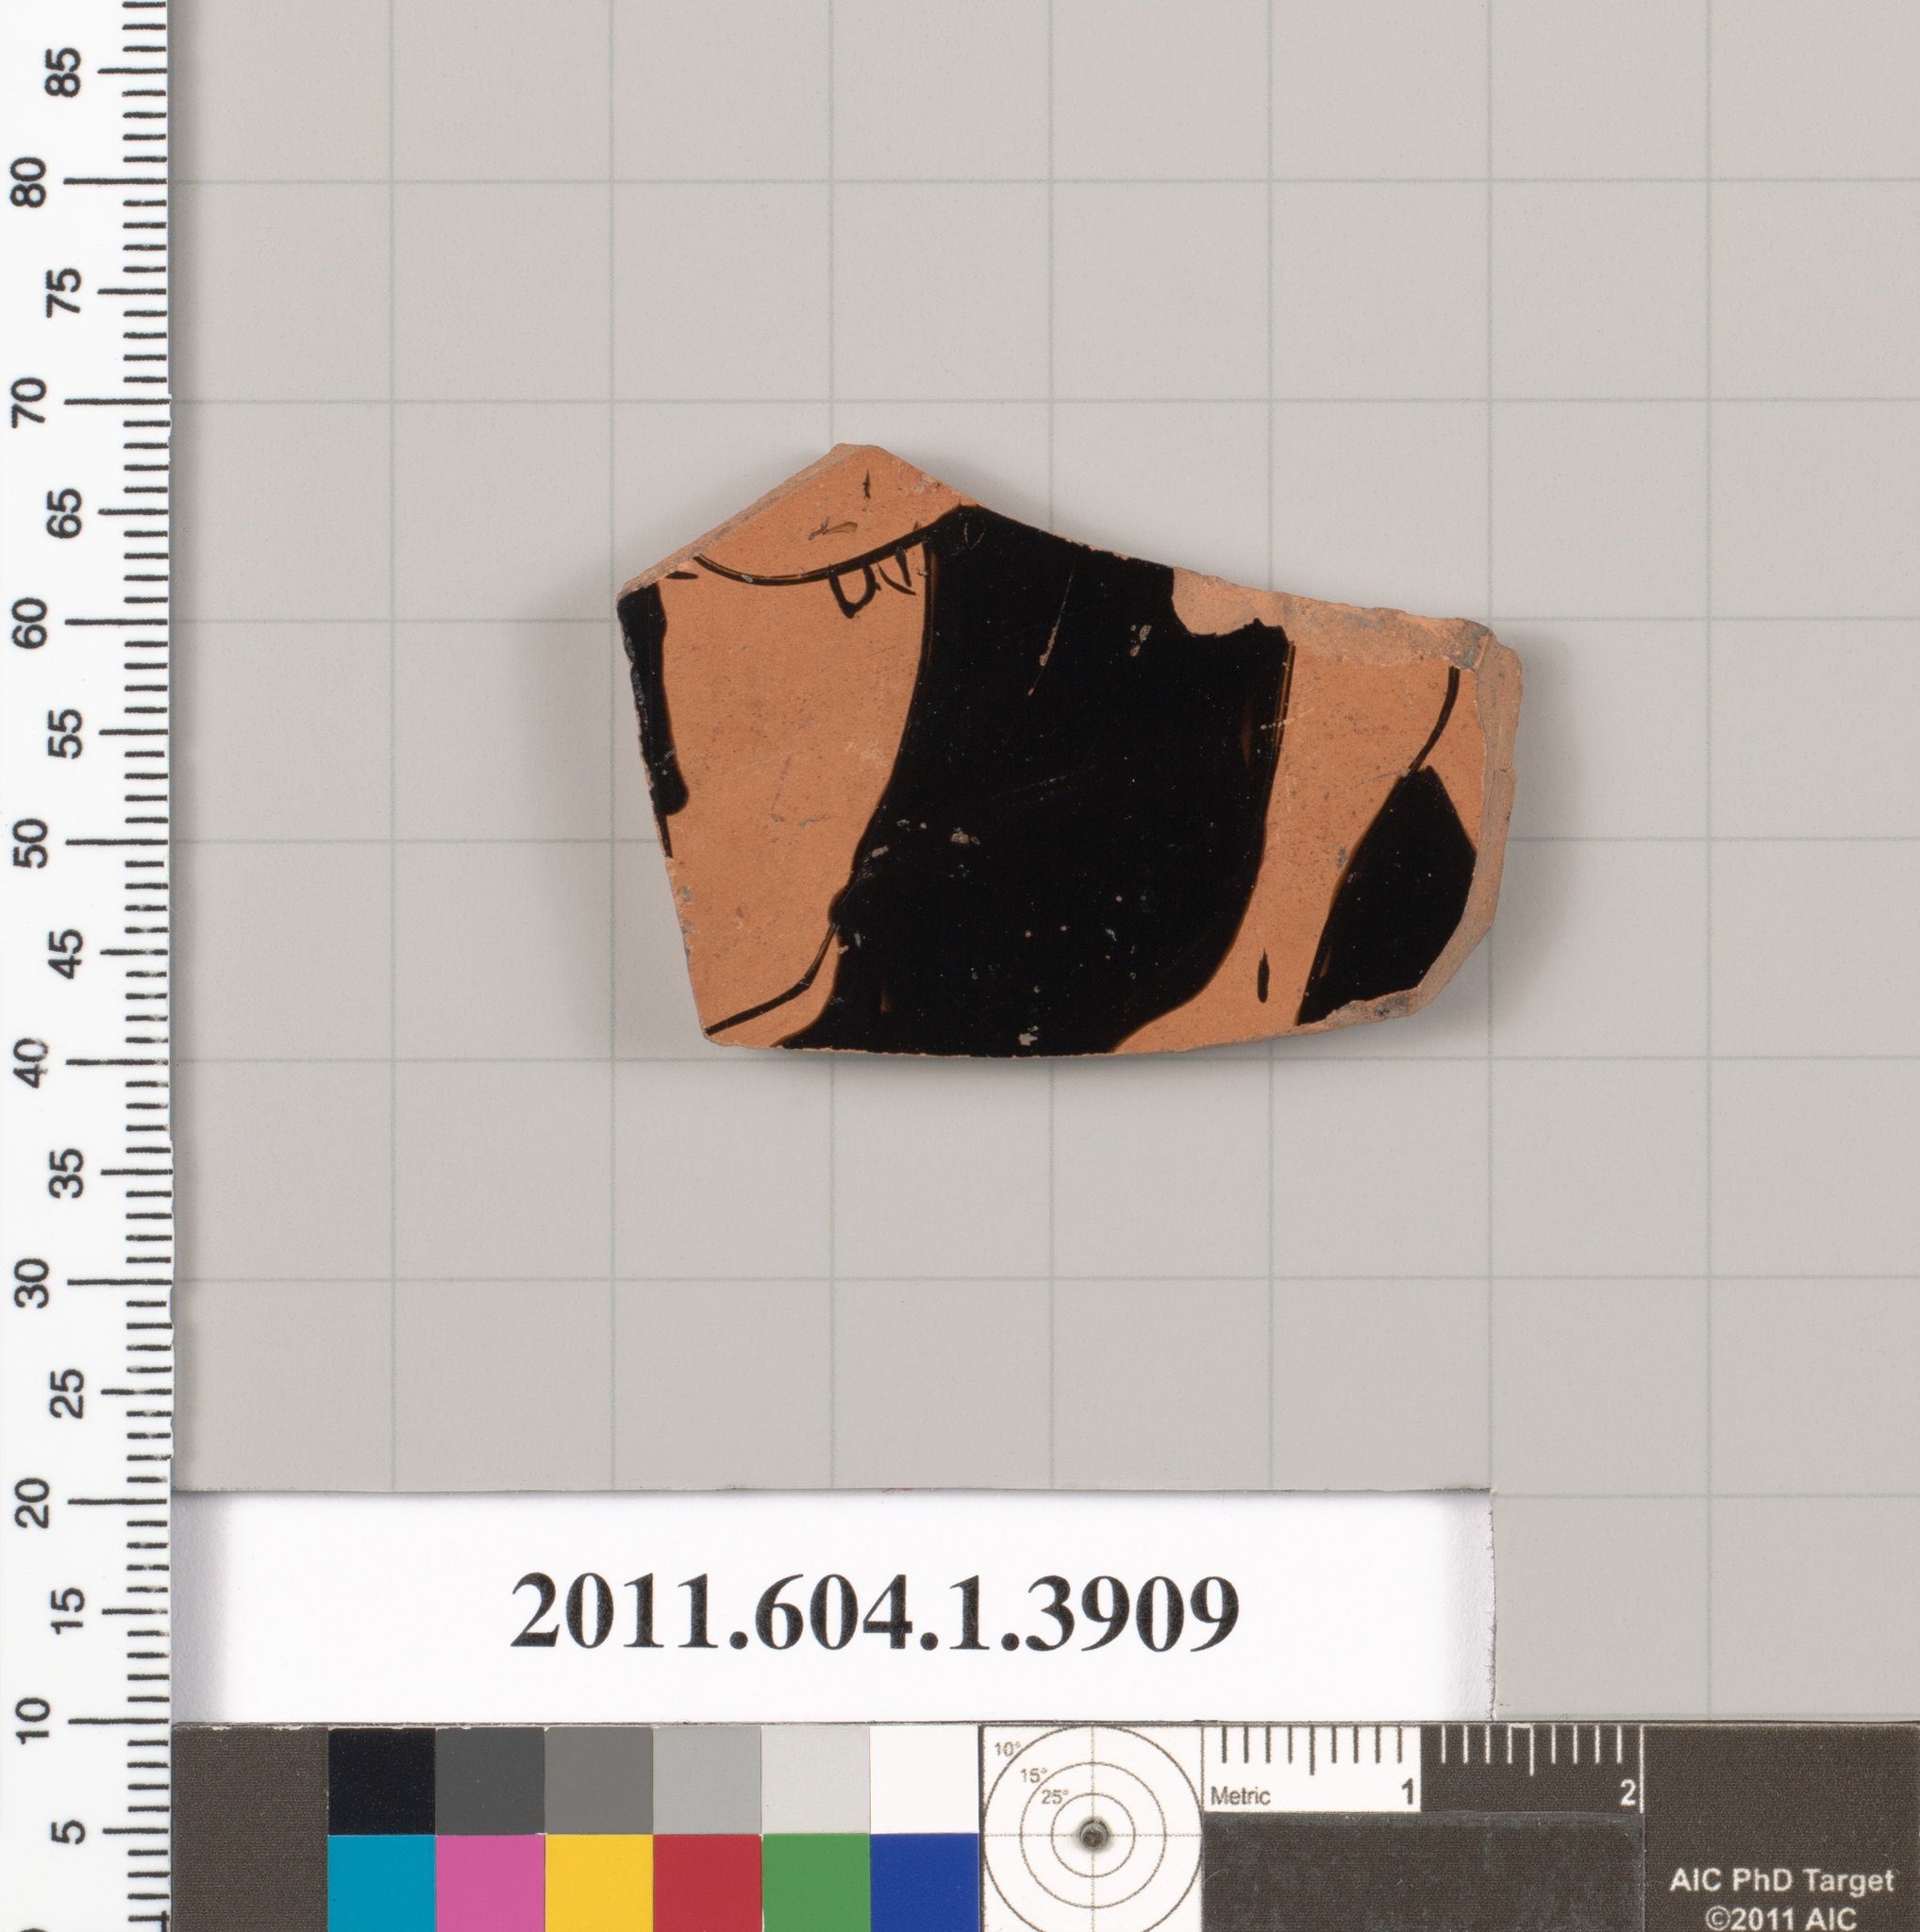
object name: kylix fragment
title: Terracotta fragment of a kylix (drinking cup)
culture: greek, attic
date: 500-476 BCE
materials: terracotta